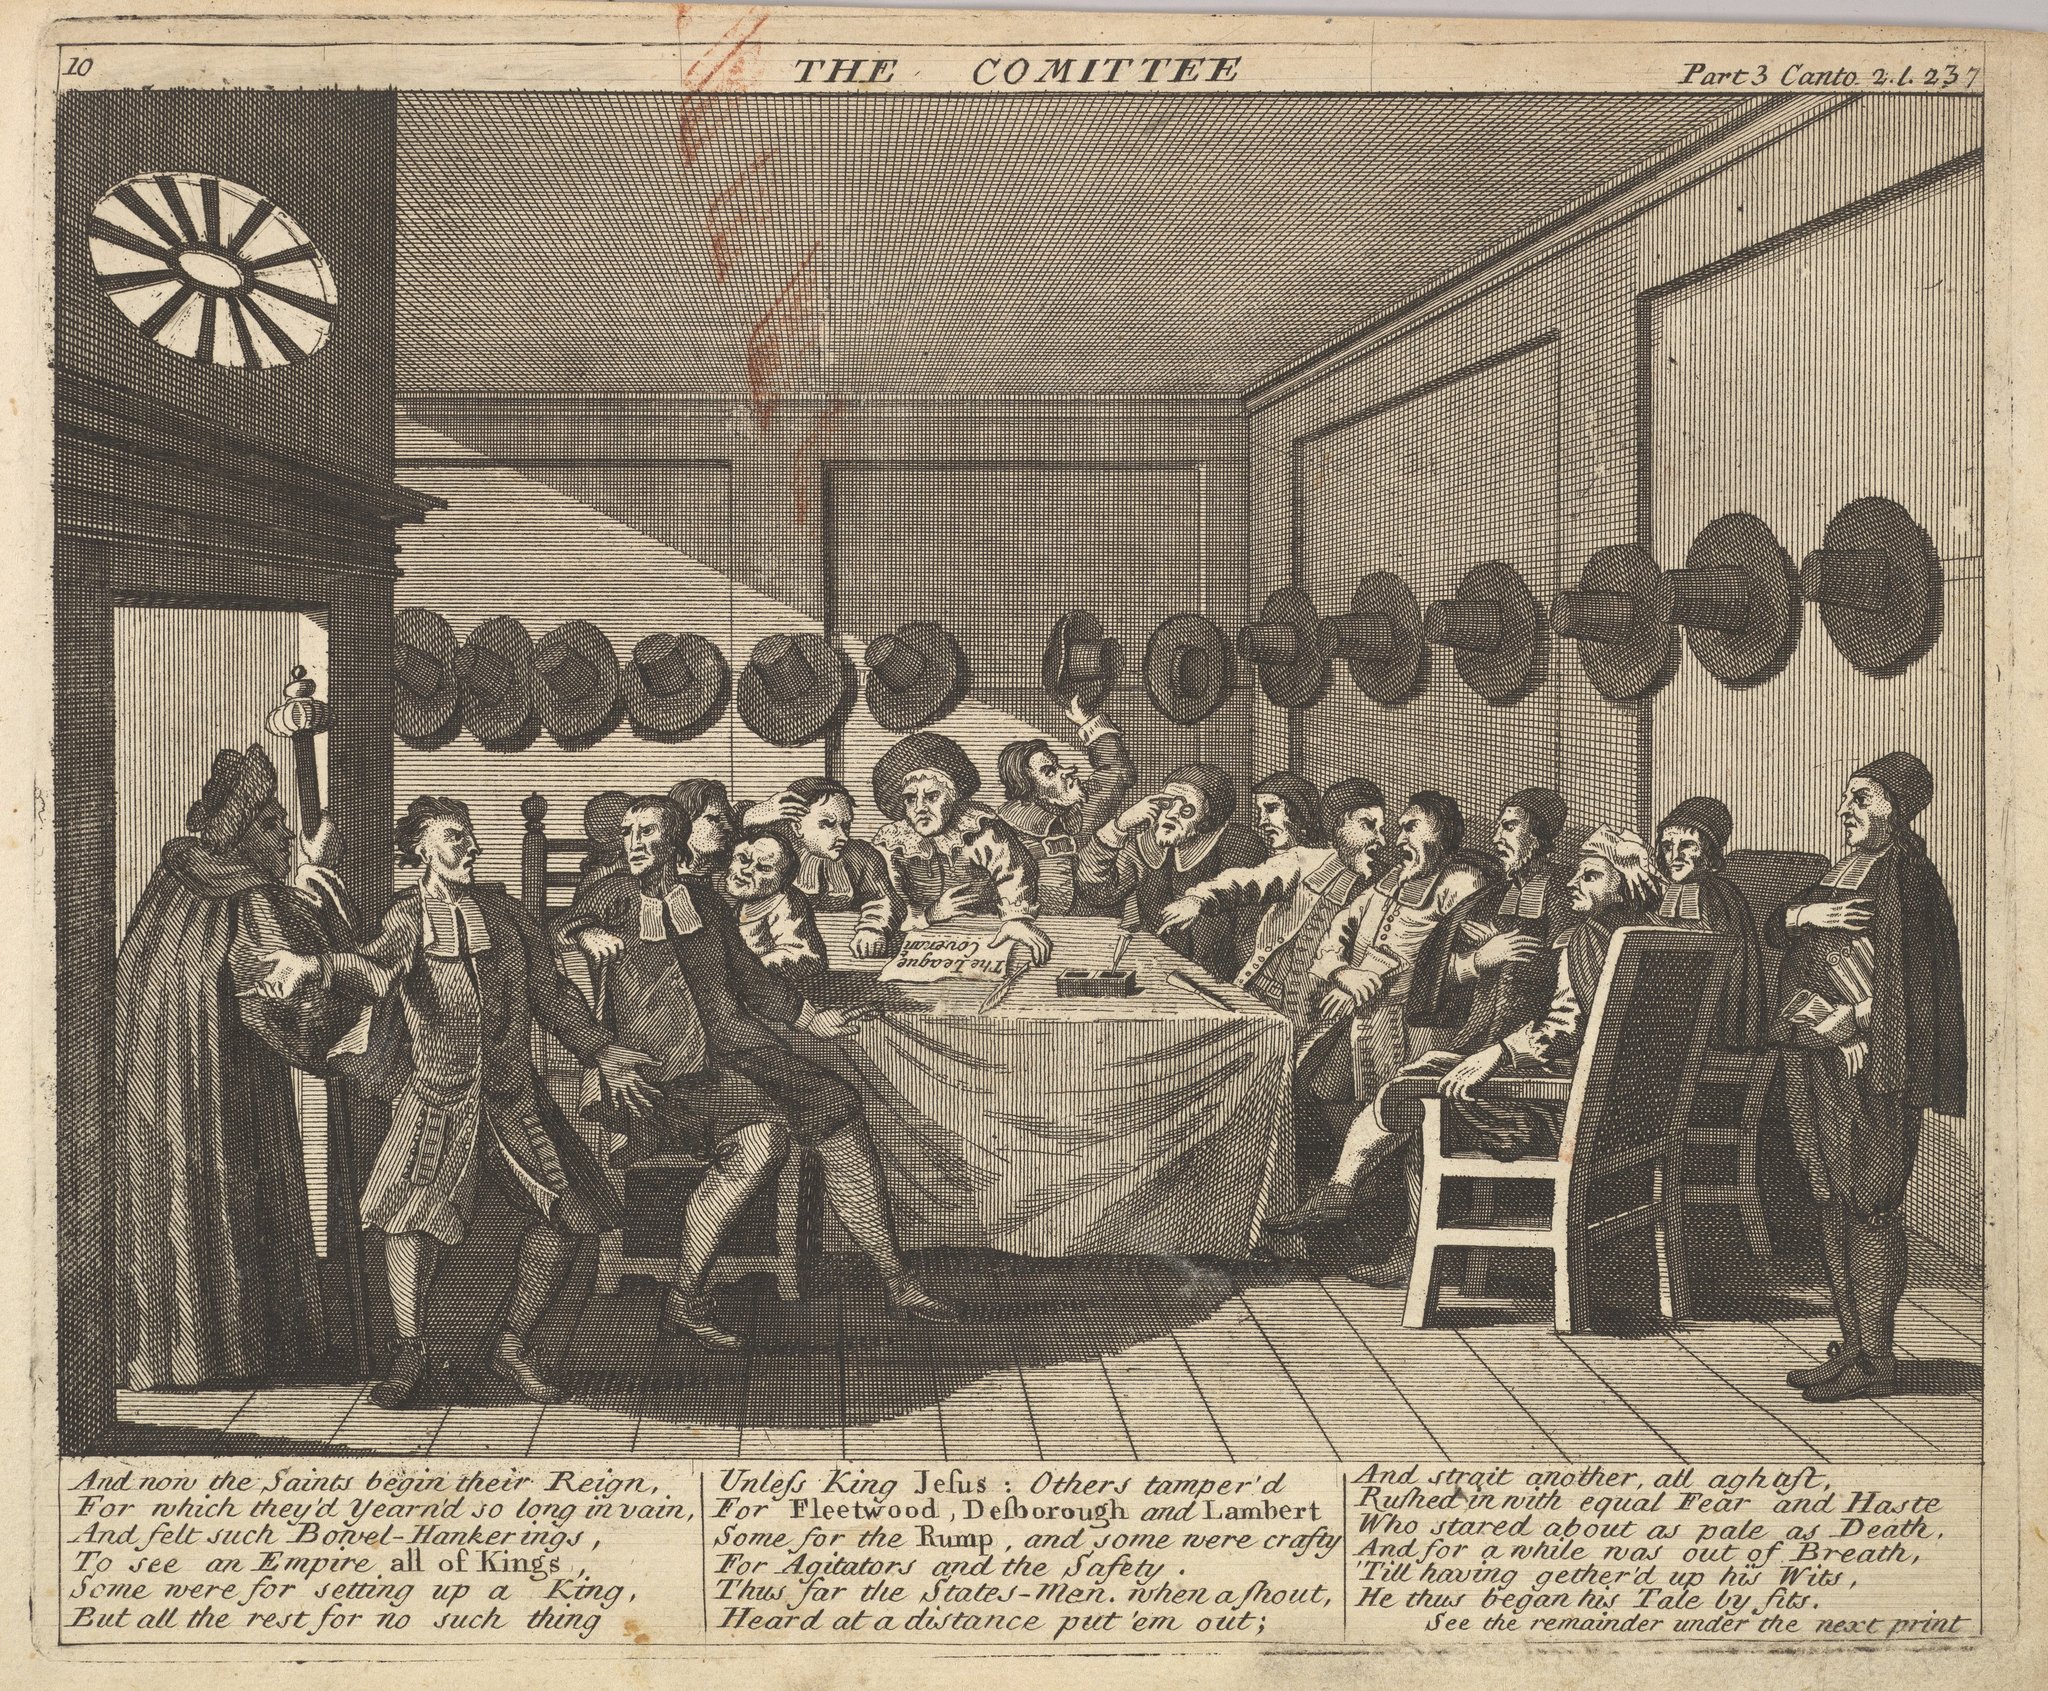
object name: print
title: The Committee (Plate 10: Illustrations to Samuel Butler's Hudibras)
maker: william hogarth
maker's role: artist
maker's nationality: british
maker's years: 1697-1764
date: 1725-1730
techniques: engraving, etching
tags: hats,men